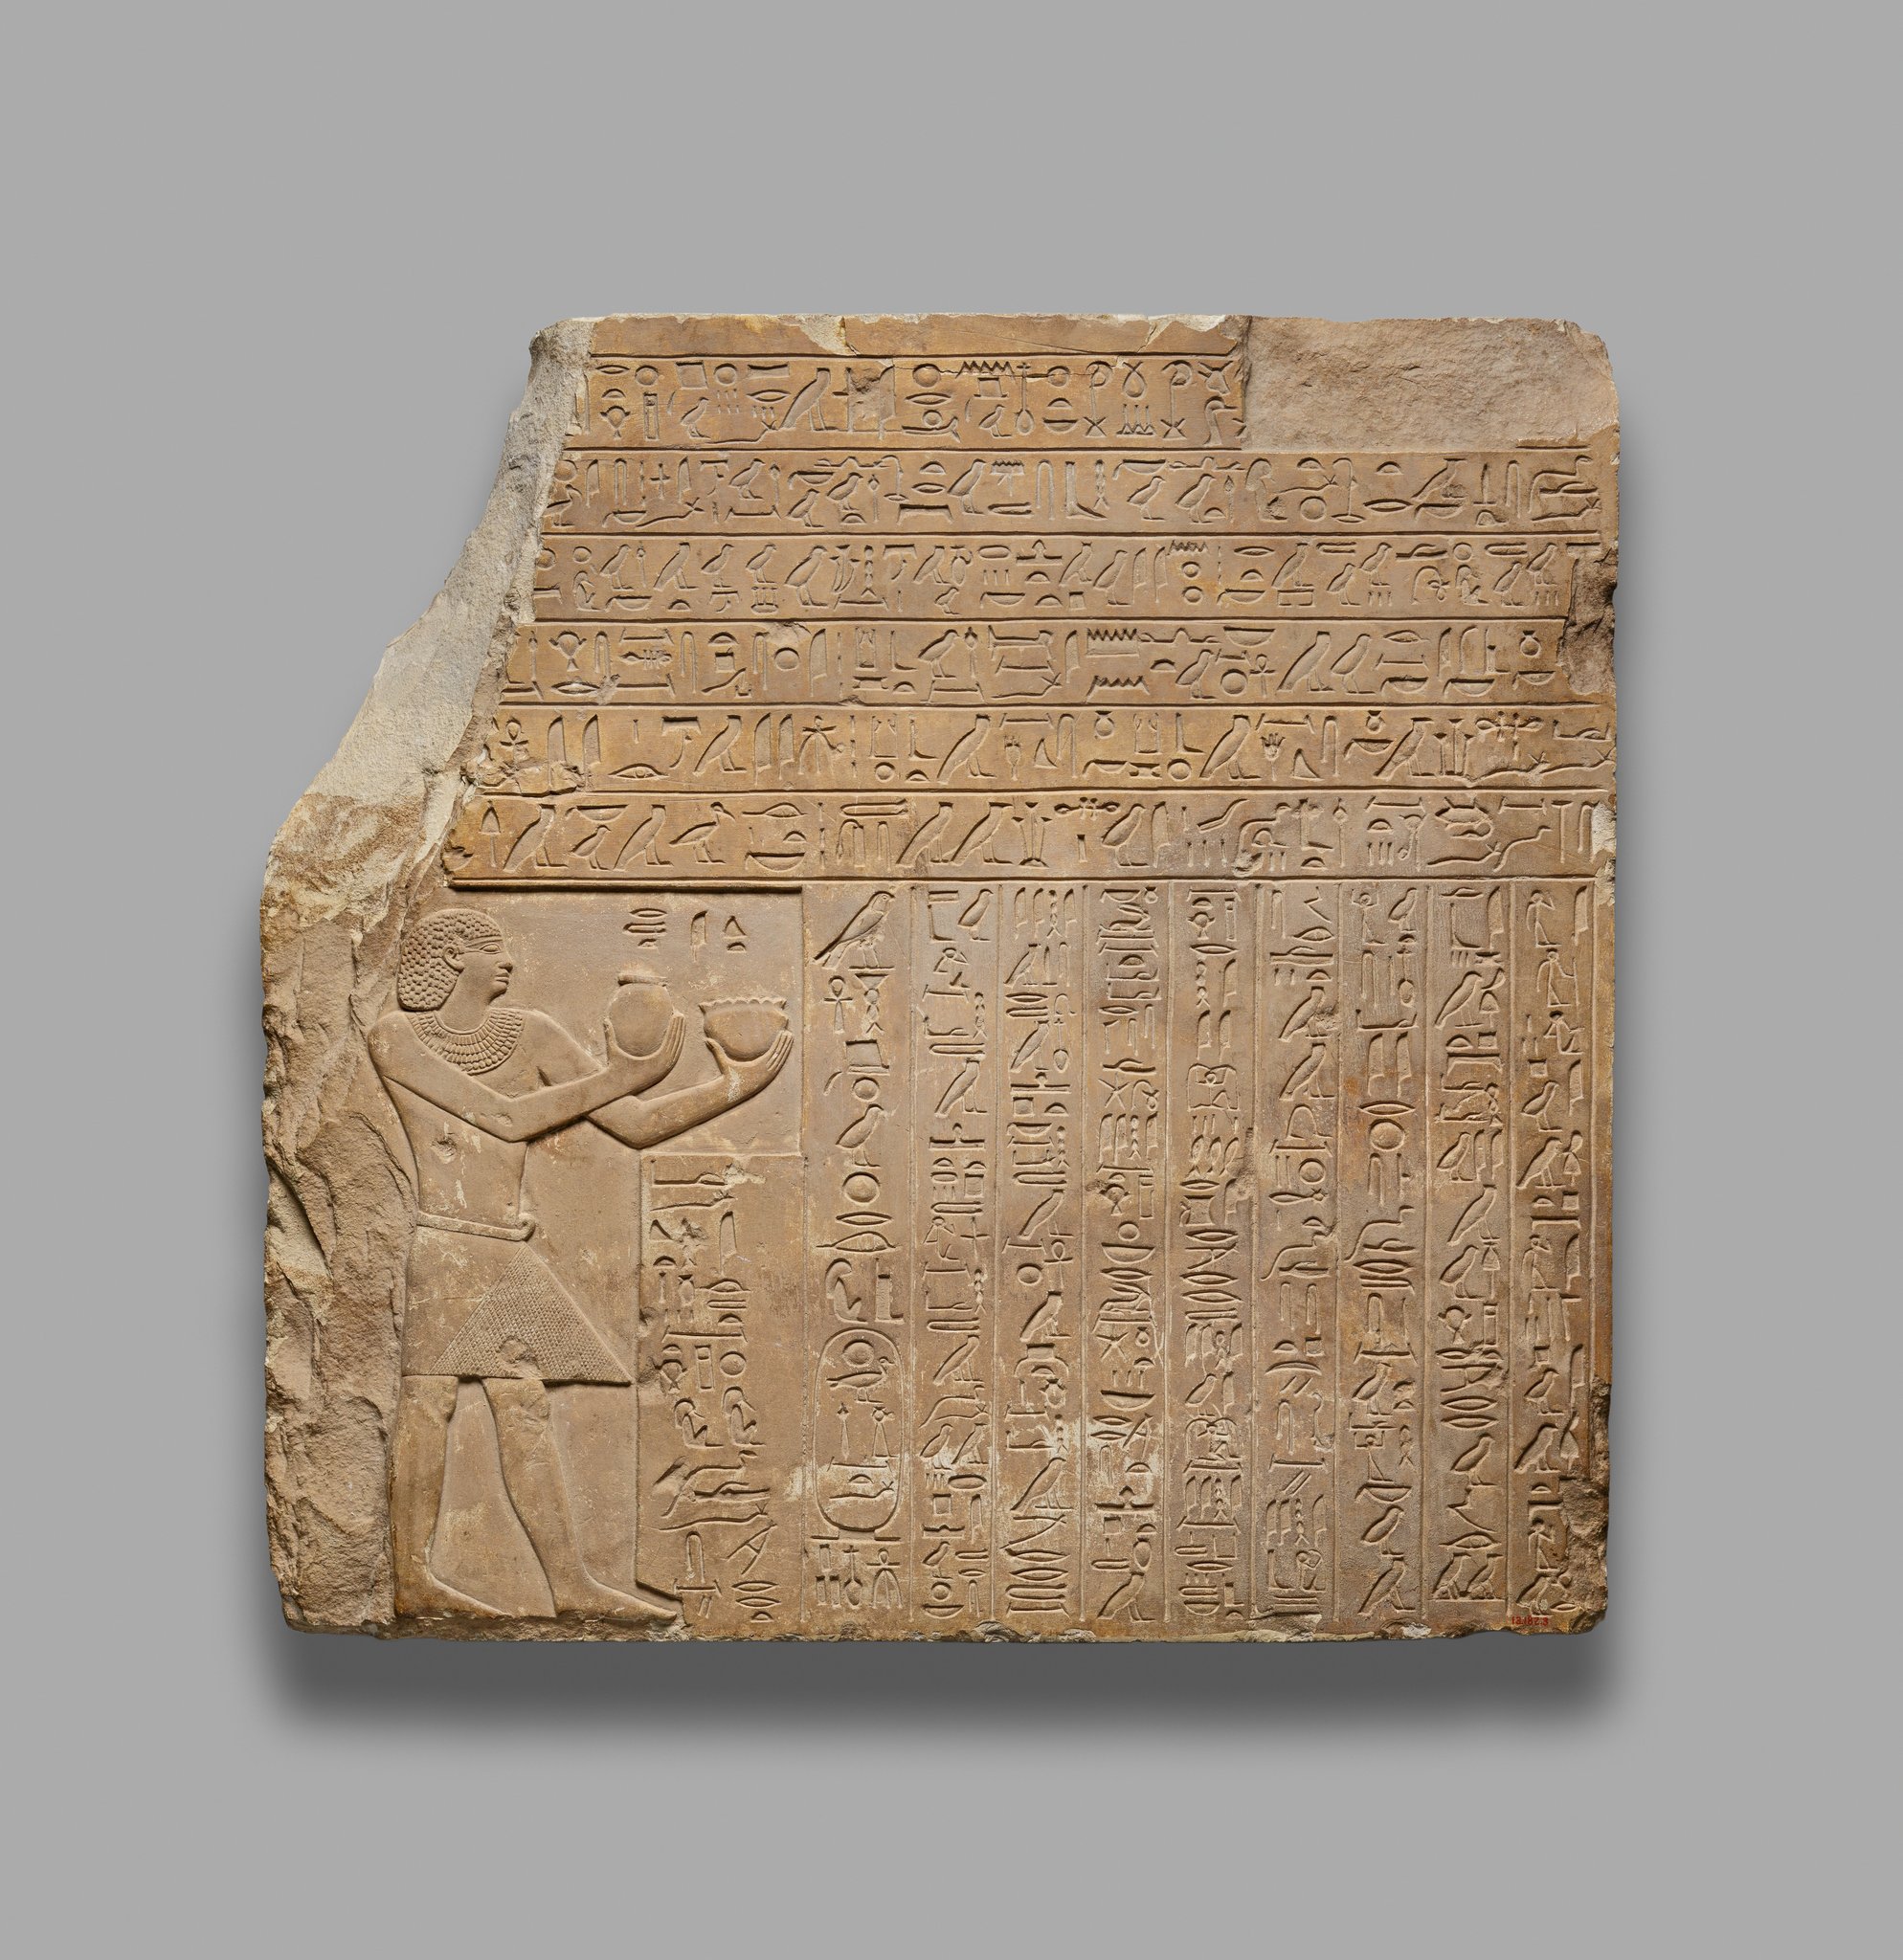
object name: stela, intef ii wahankh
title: Stela of King Intef II Wahankh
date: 2108-2059 BCE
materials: limestone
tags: hieroglyphs,horus